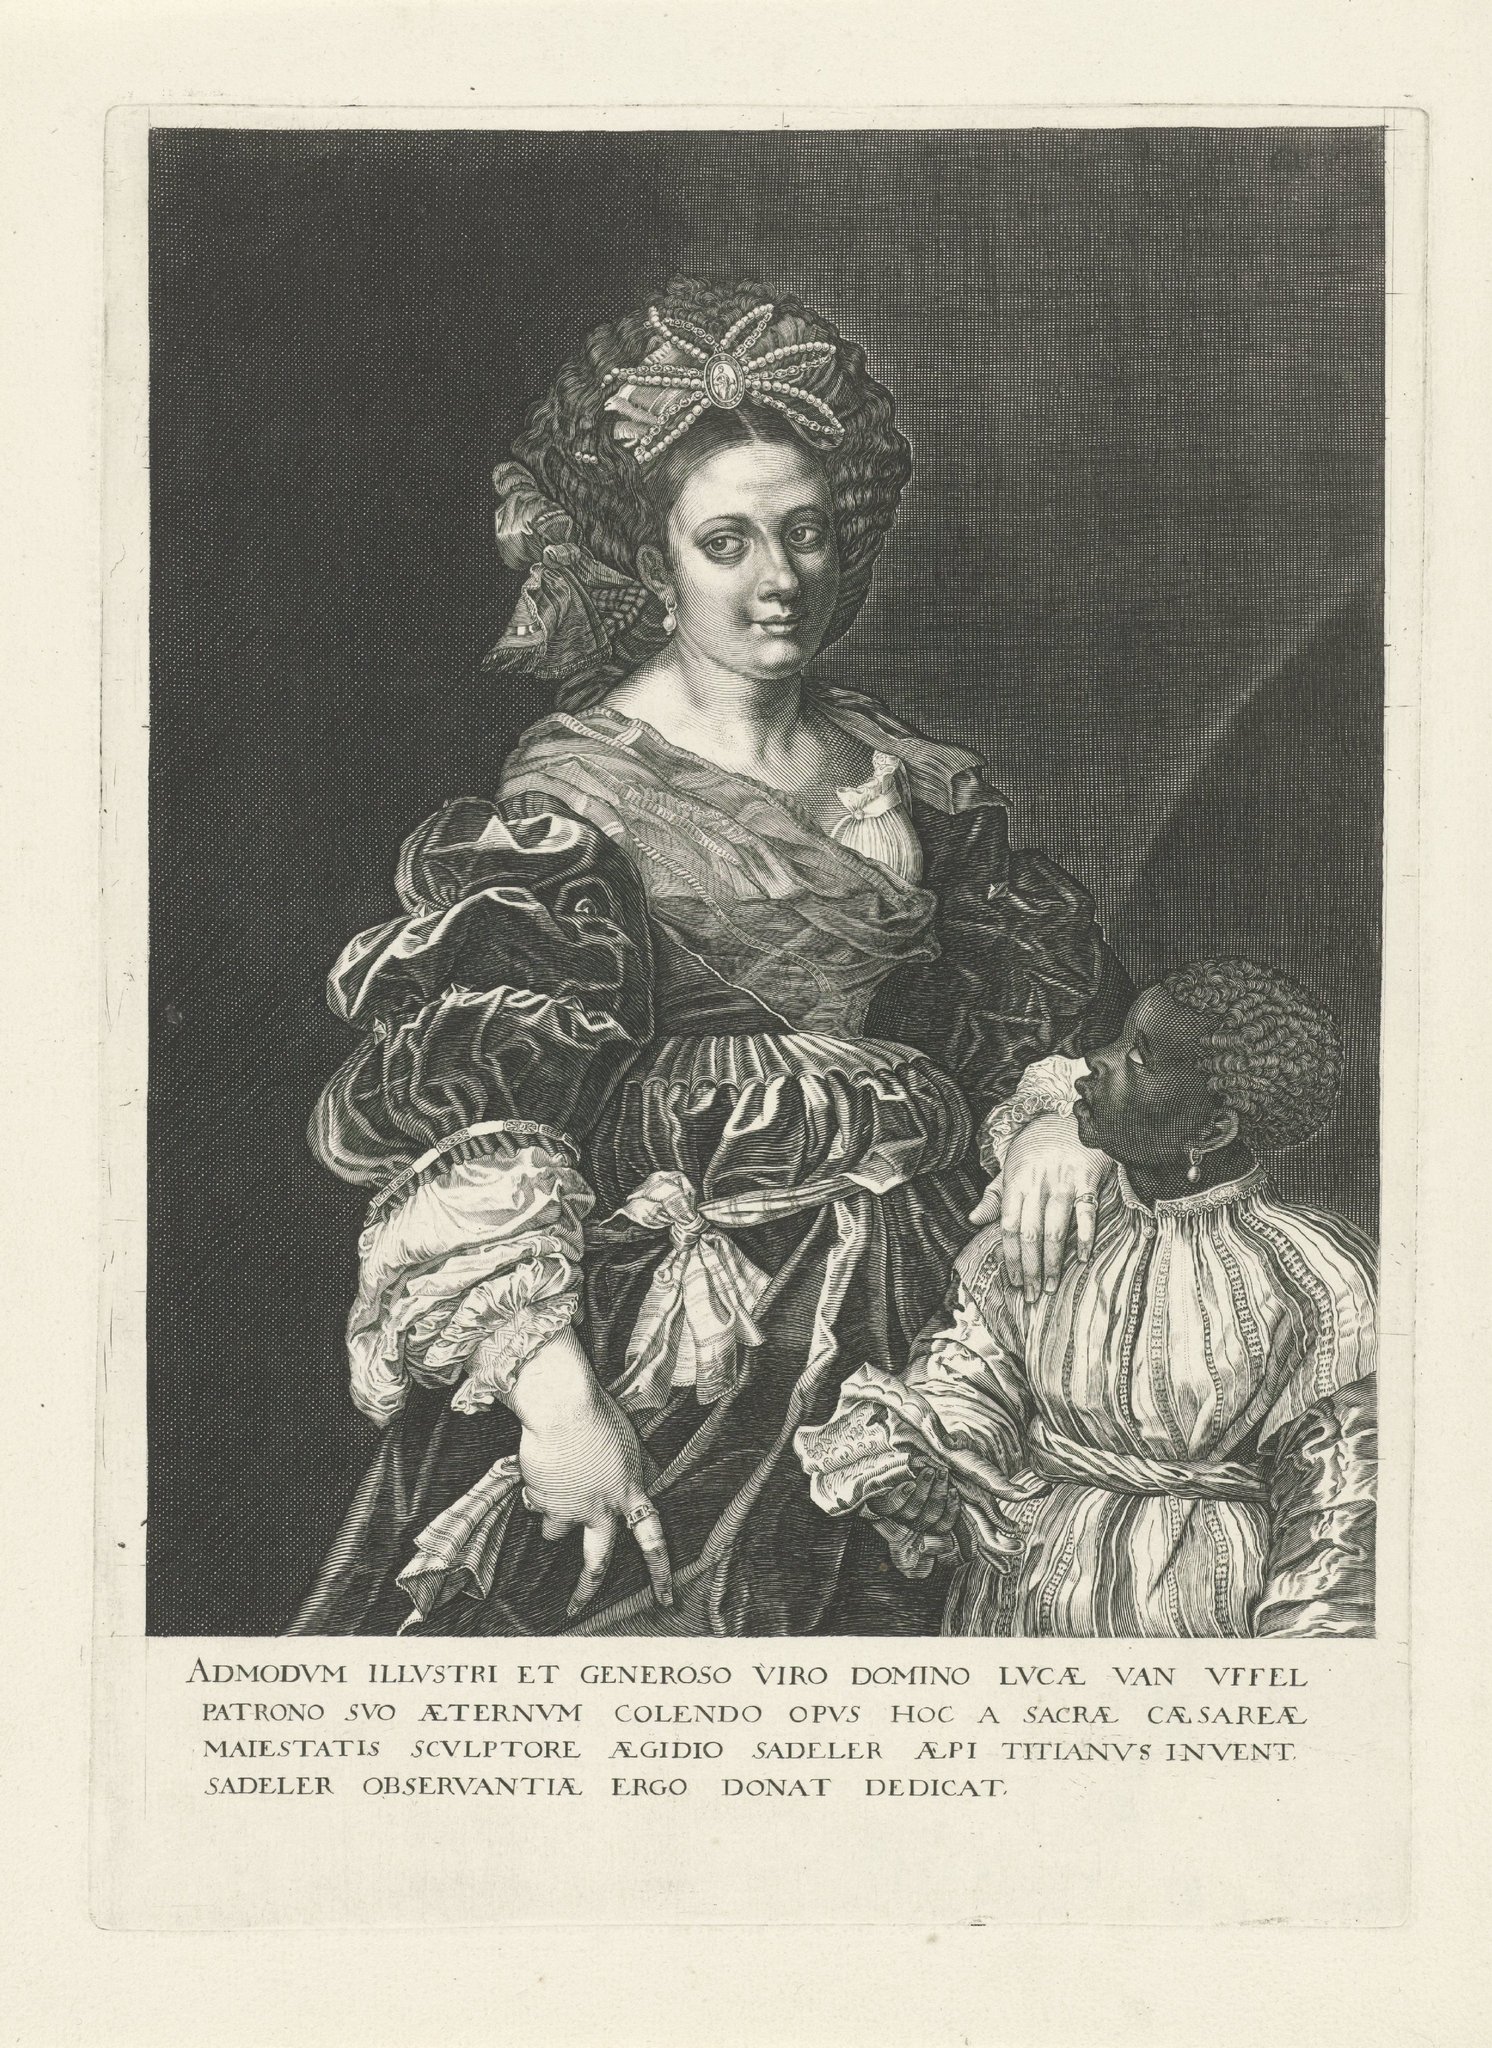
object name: print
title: Portret van Laura de' Dianti en een tot slaaf gemaakte bediende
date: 1580-1629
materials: paper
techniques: engraving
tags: master ~ enslaved person, africans, slavery; serfs and enslaved persons, manservant, footman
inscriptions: collector's mark: Lugt 240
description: Laura de' Dianti, de vrouw en vroegere minnares van hertog Alfonso I d'Este. Naast haar een tot slaaf gemaakte Afrikaanse bediende.